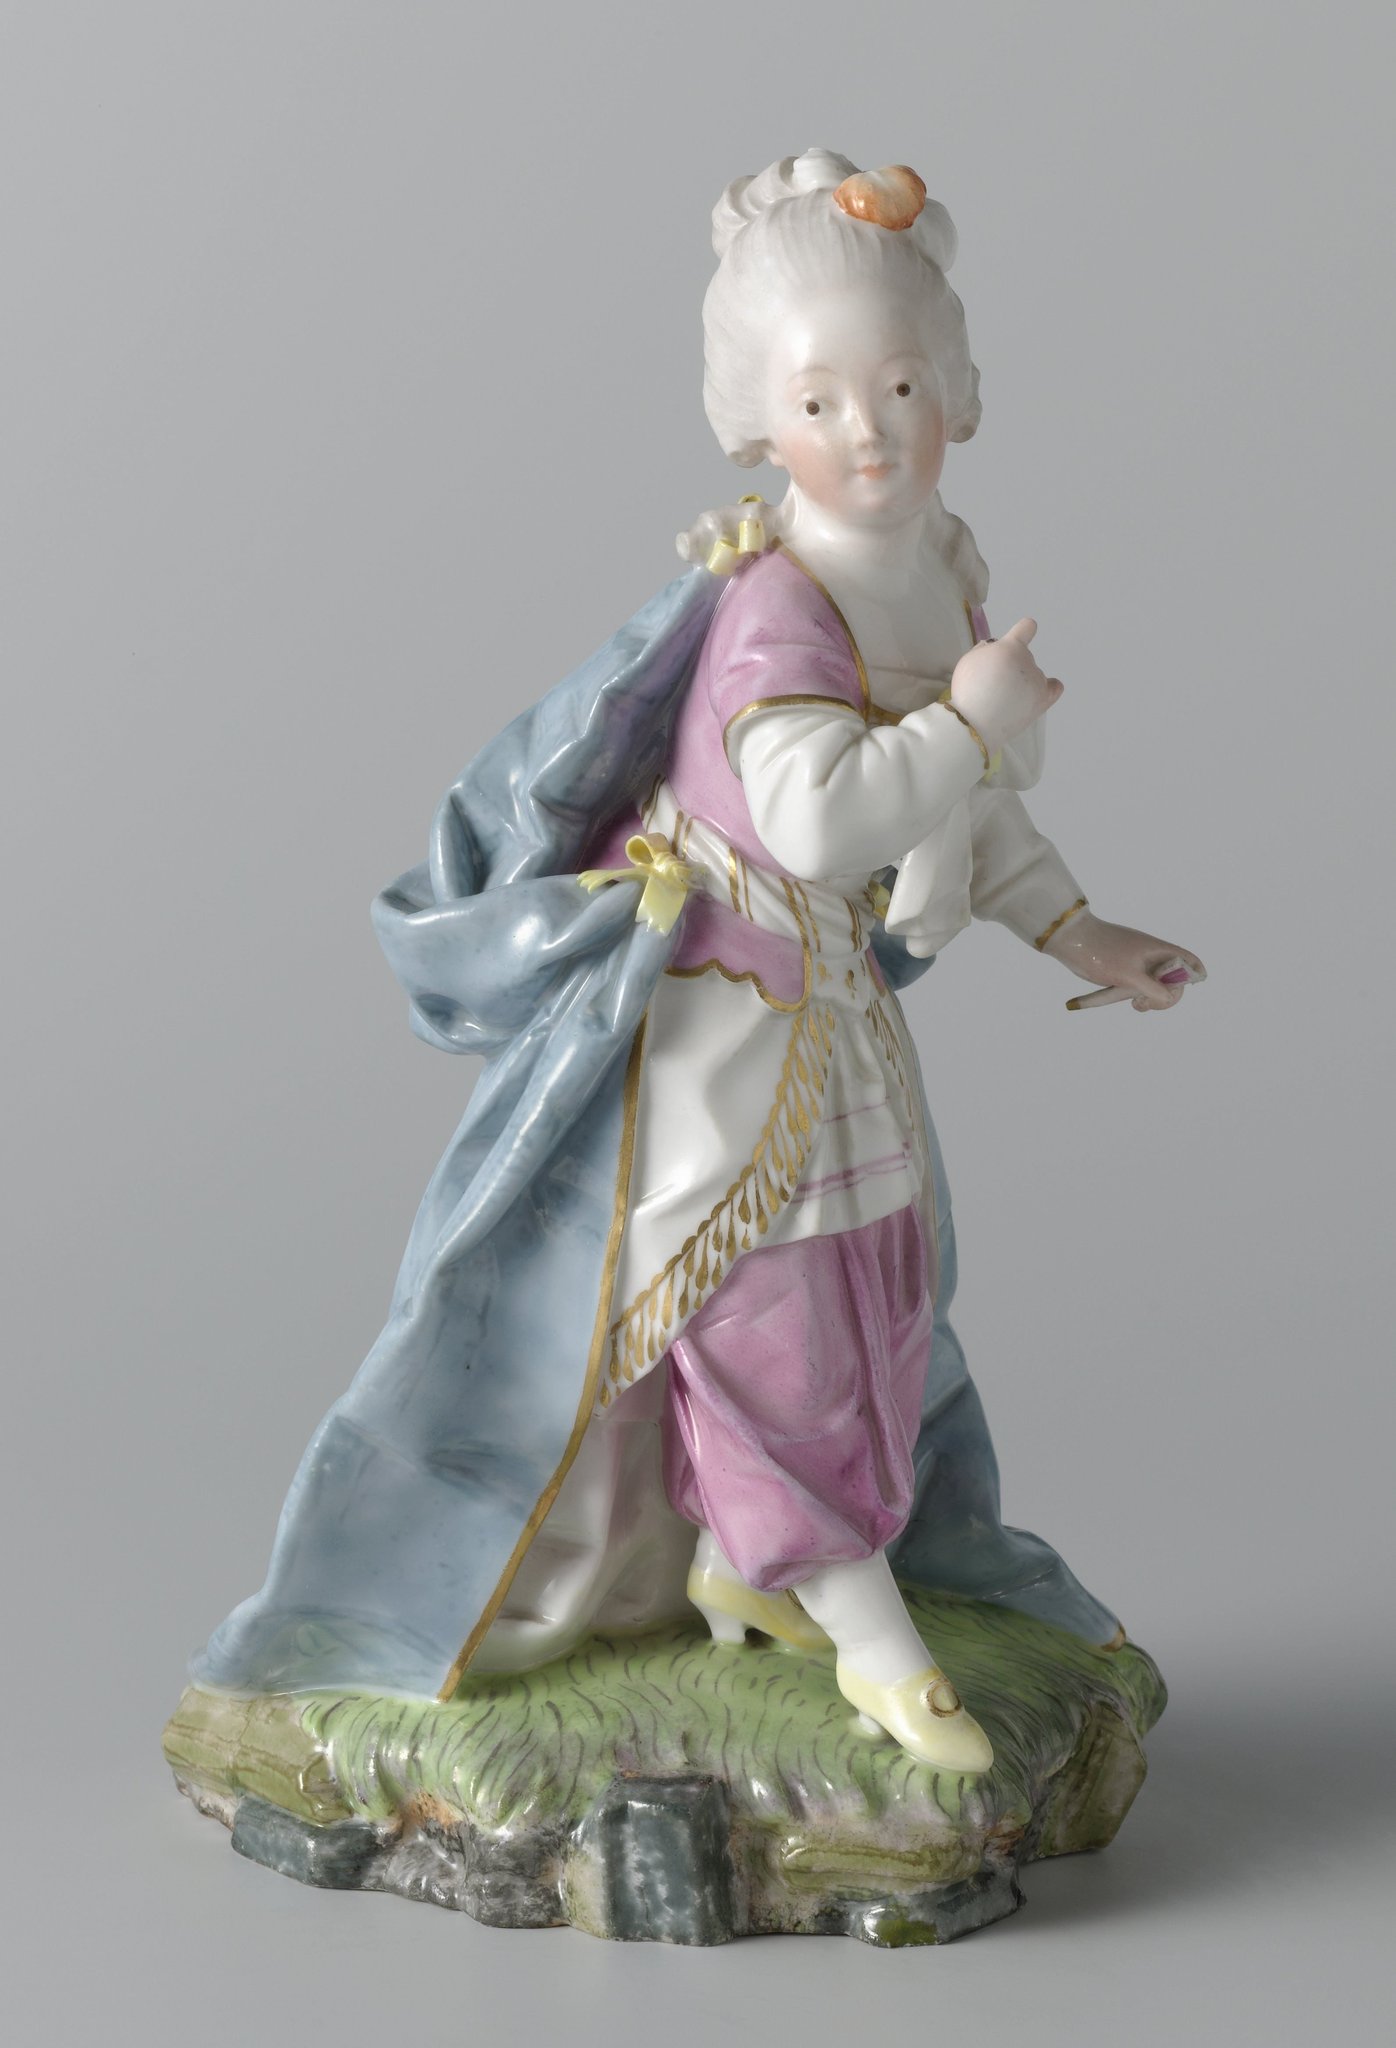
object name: figure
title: Boy and Girl in Oriental Dress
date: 1767-1775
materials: glaze, gold, paint, porcelain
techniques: firing, forming, gilding, vitrification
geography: höchst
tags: girl (child between toddler and youth), folk costume, regional costume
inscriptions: mark: ‘wiel met keurvorstenhoed/ HM’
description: Höchster Porzellanmanufaktur modelled by Johann Peter Melchior (1747–1825) Höchst, c. 1767–1775 hard-paste porcelain